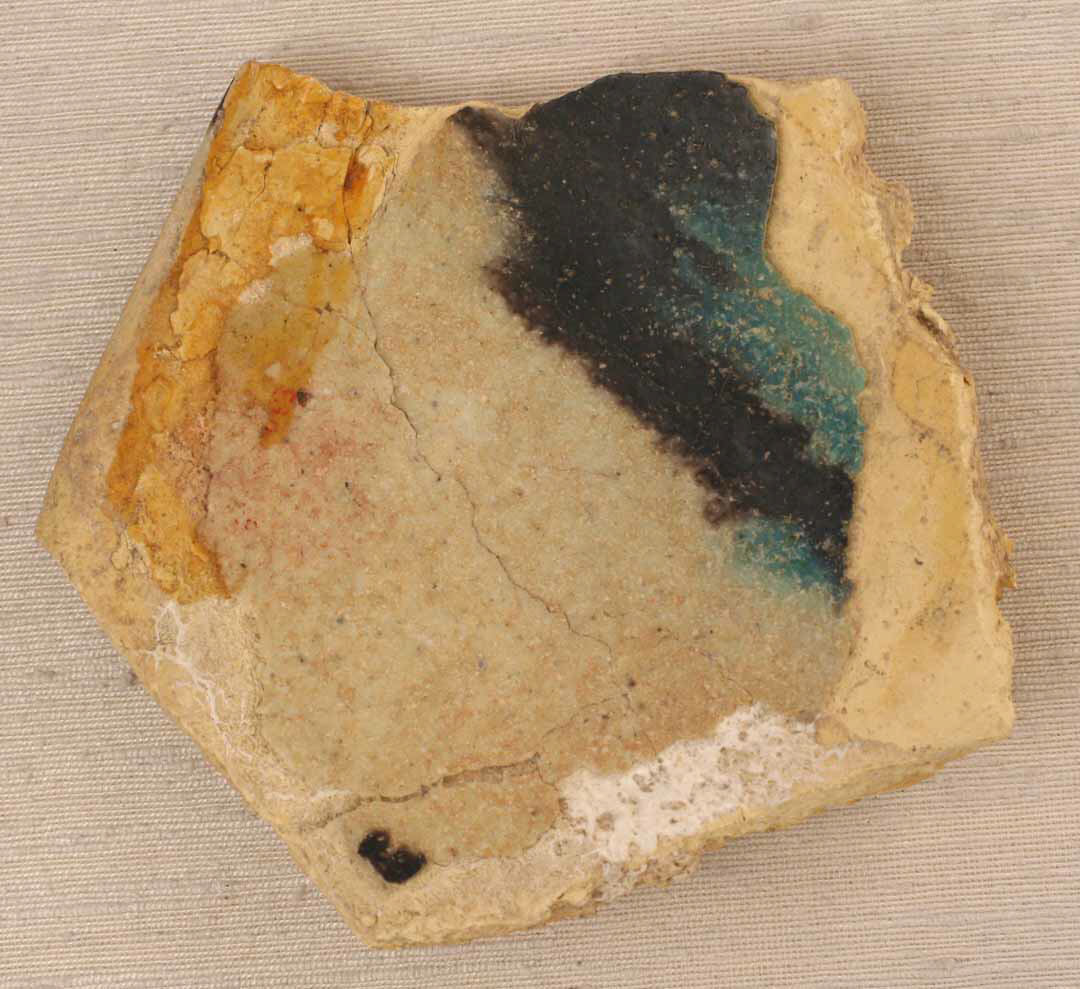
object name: fragment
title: Ceramic Fragment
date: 801-1000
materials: earthenware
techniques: glazing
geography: saudi arabia